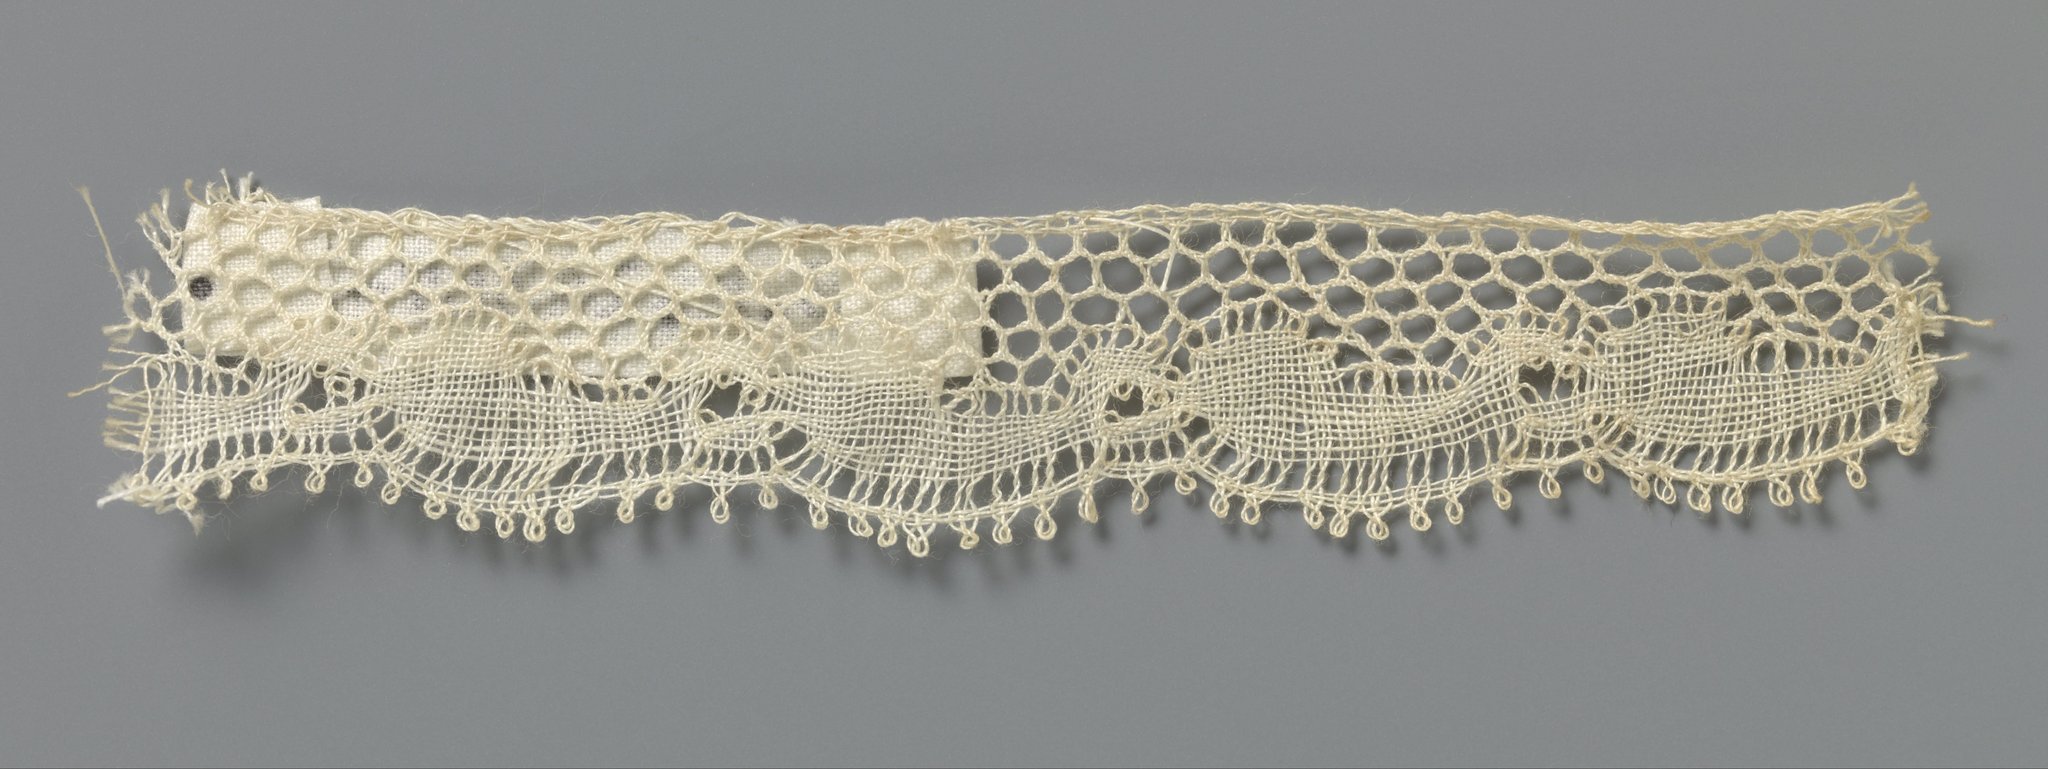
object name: strip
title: Strook kloskant met cirkeltjes en komma's langs onderzijde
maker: Anonymous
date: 1900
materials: cotton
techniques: lace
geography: france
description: Strook naturelkleurige kloskant, Valenciennes-kant. Het doorlopende patroon bestaat langs de onderzijde van de strook uit een aaneenschakeling van een cirkeltje en een liggende komma. Hierboven bestaat de strook uit een maasgrond, een ronde Valenciennes-grond. De motieven zijn gemaakt in losgewerkte linnenslag met opengewerkte randjes. De bovenzijde van de strook is recht afgewerkt. De schulpen langs de onderzijde zijn afgewerkt met picots.